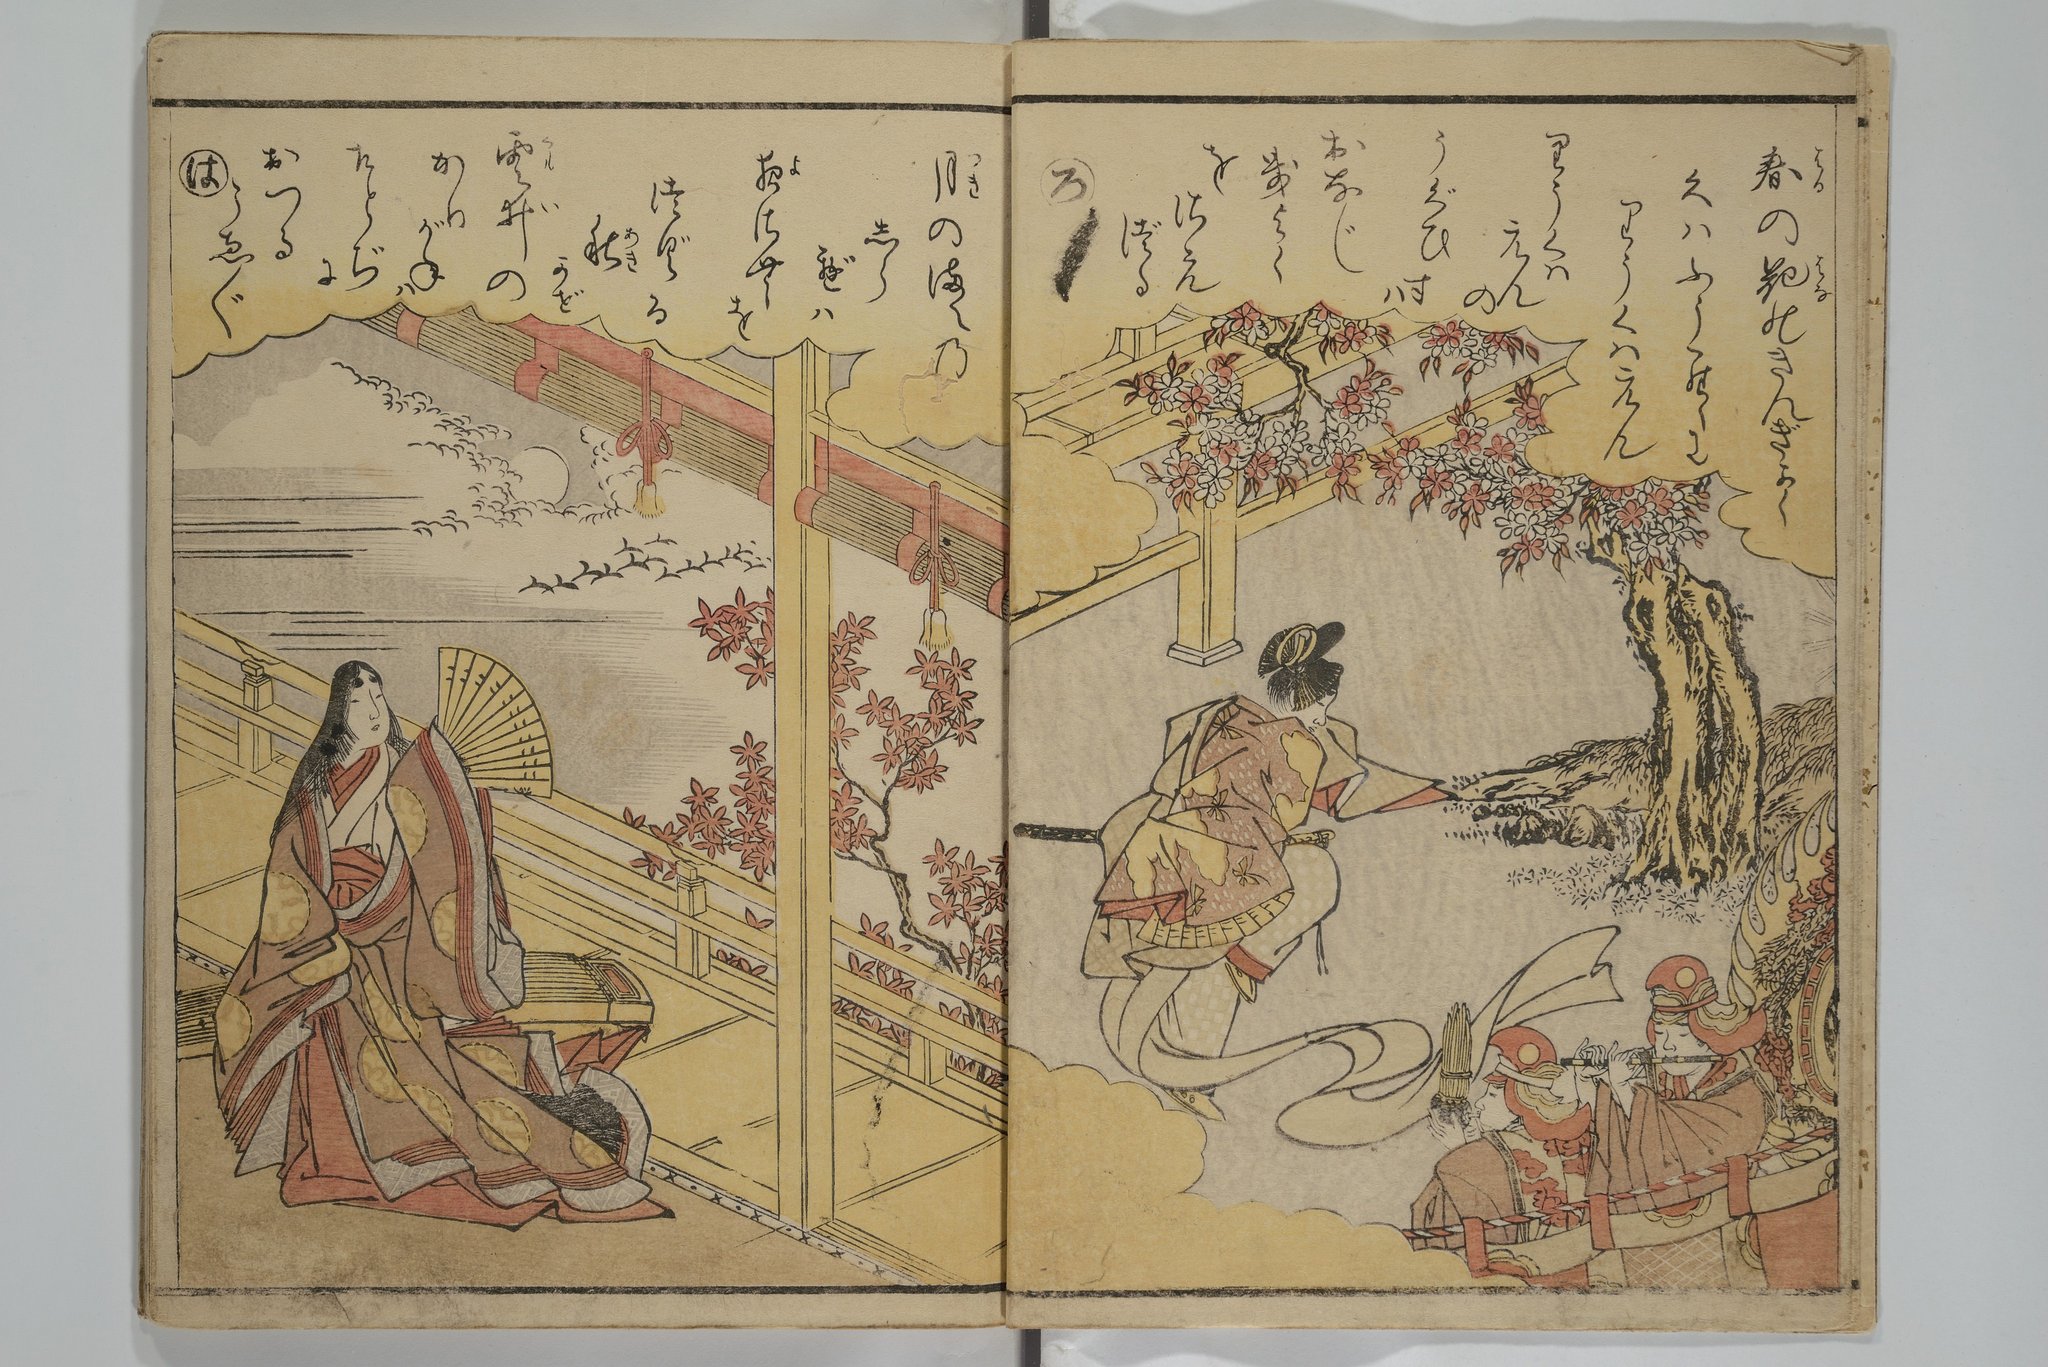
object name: illustrated book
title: Picture Book on the Music of the Pine Trees (Ehon matsu no shirabe) 絵本松のしらべ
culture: japanese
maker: katsukawa shunshō 勝川春章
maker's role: artist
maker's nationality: japanese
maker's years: 1726-1792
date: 1795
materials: ink, paper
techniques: woodblock print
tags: men,women,landscapes,musicians